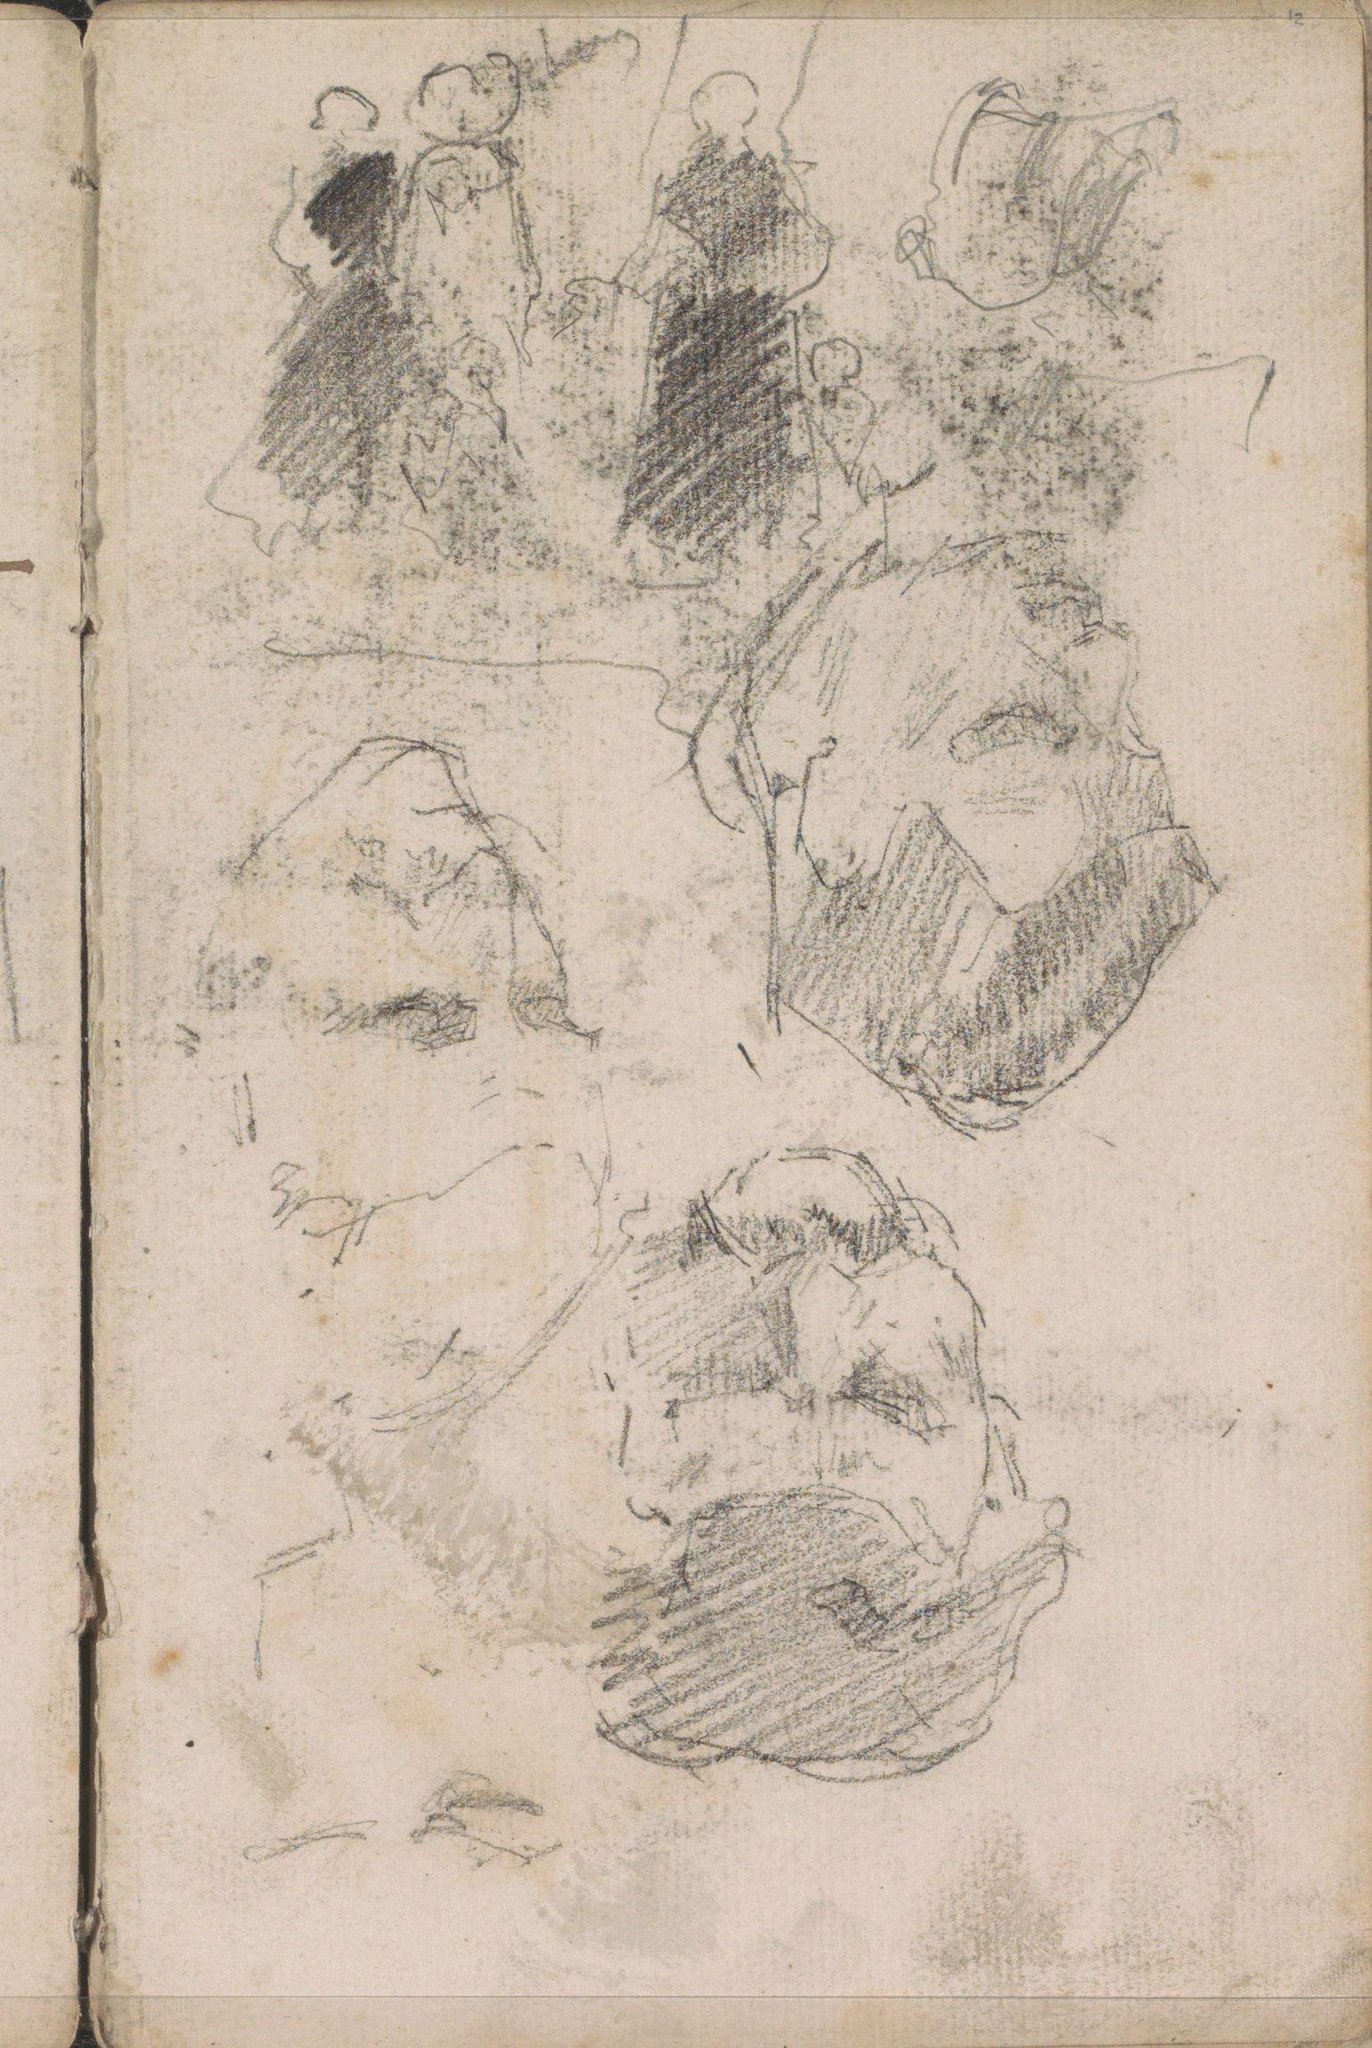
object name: sketchbook leaf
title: Staande vrouwen, een zadel en mannenhoofden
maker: george hendrik breitner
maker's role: draughtsman, painter, print maker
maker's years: 1857-1923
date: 1880-1882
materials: chalk, paper, pencil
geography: the hague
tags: head (human), adult woman, adult man, standing figure - aa - female human figure, saddle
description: Pagina 12 uit een schetsboek met 29 bladen.